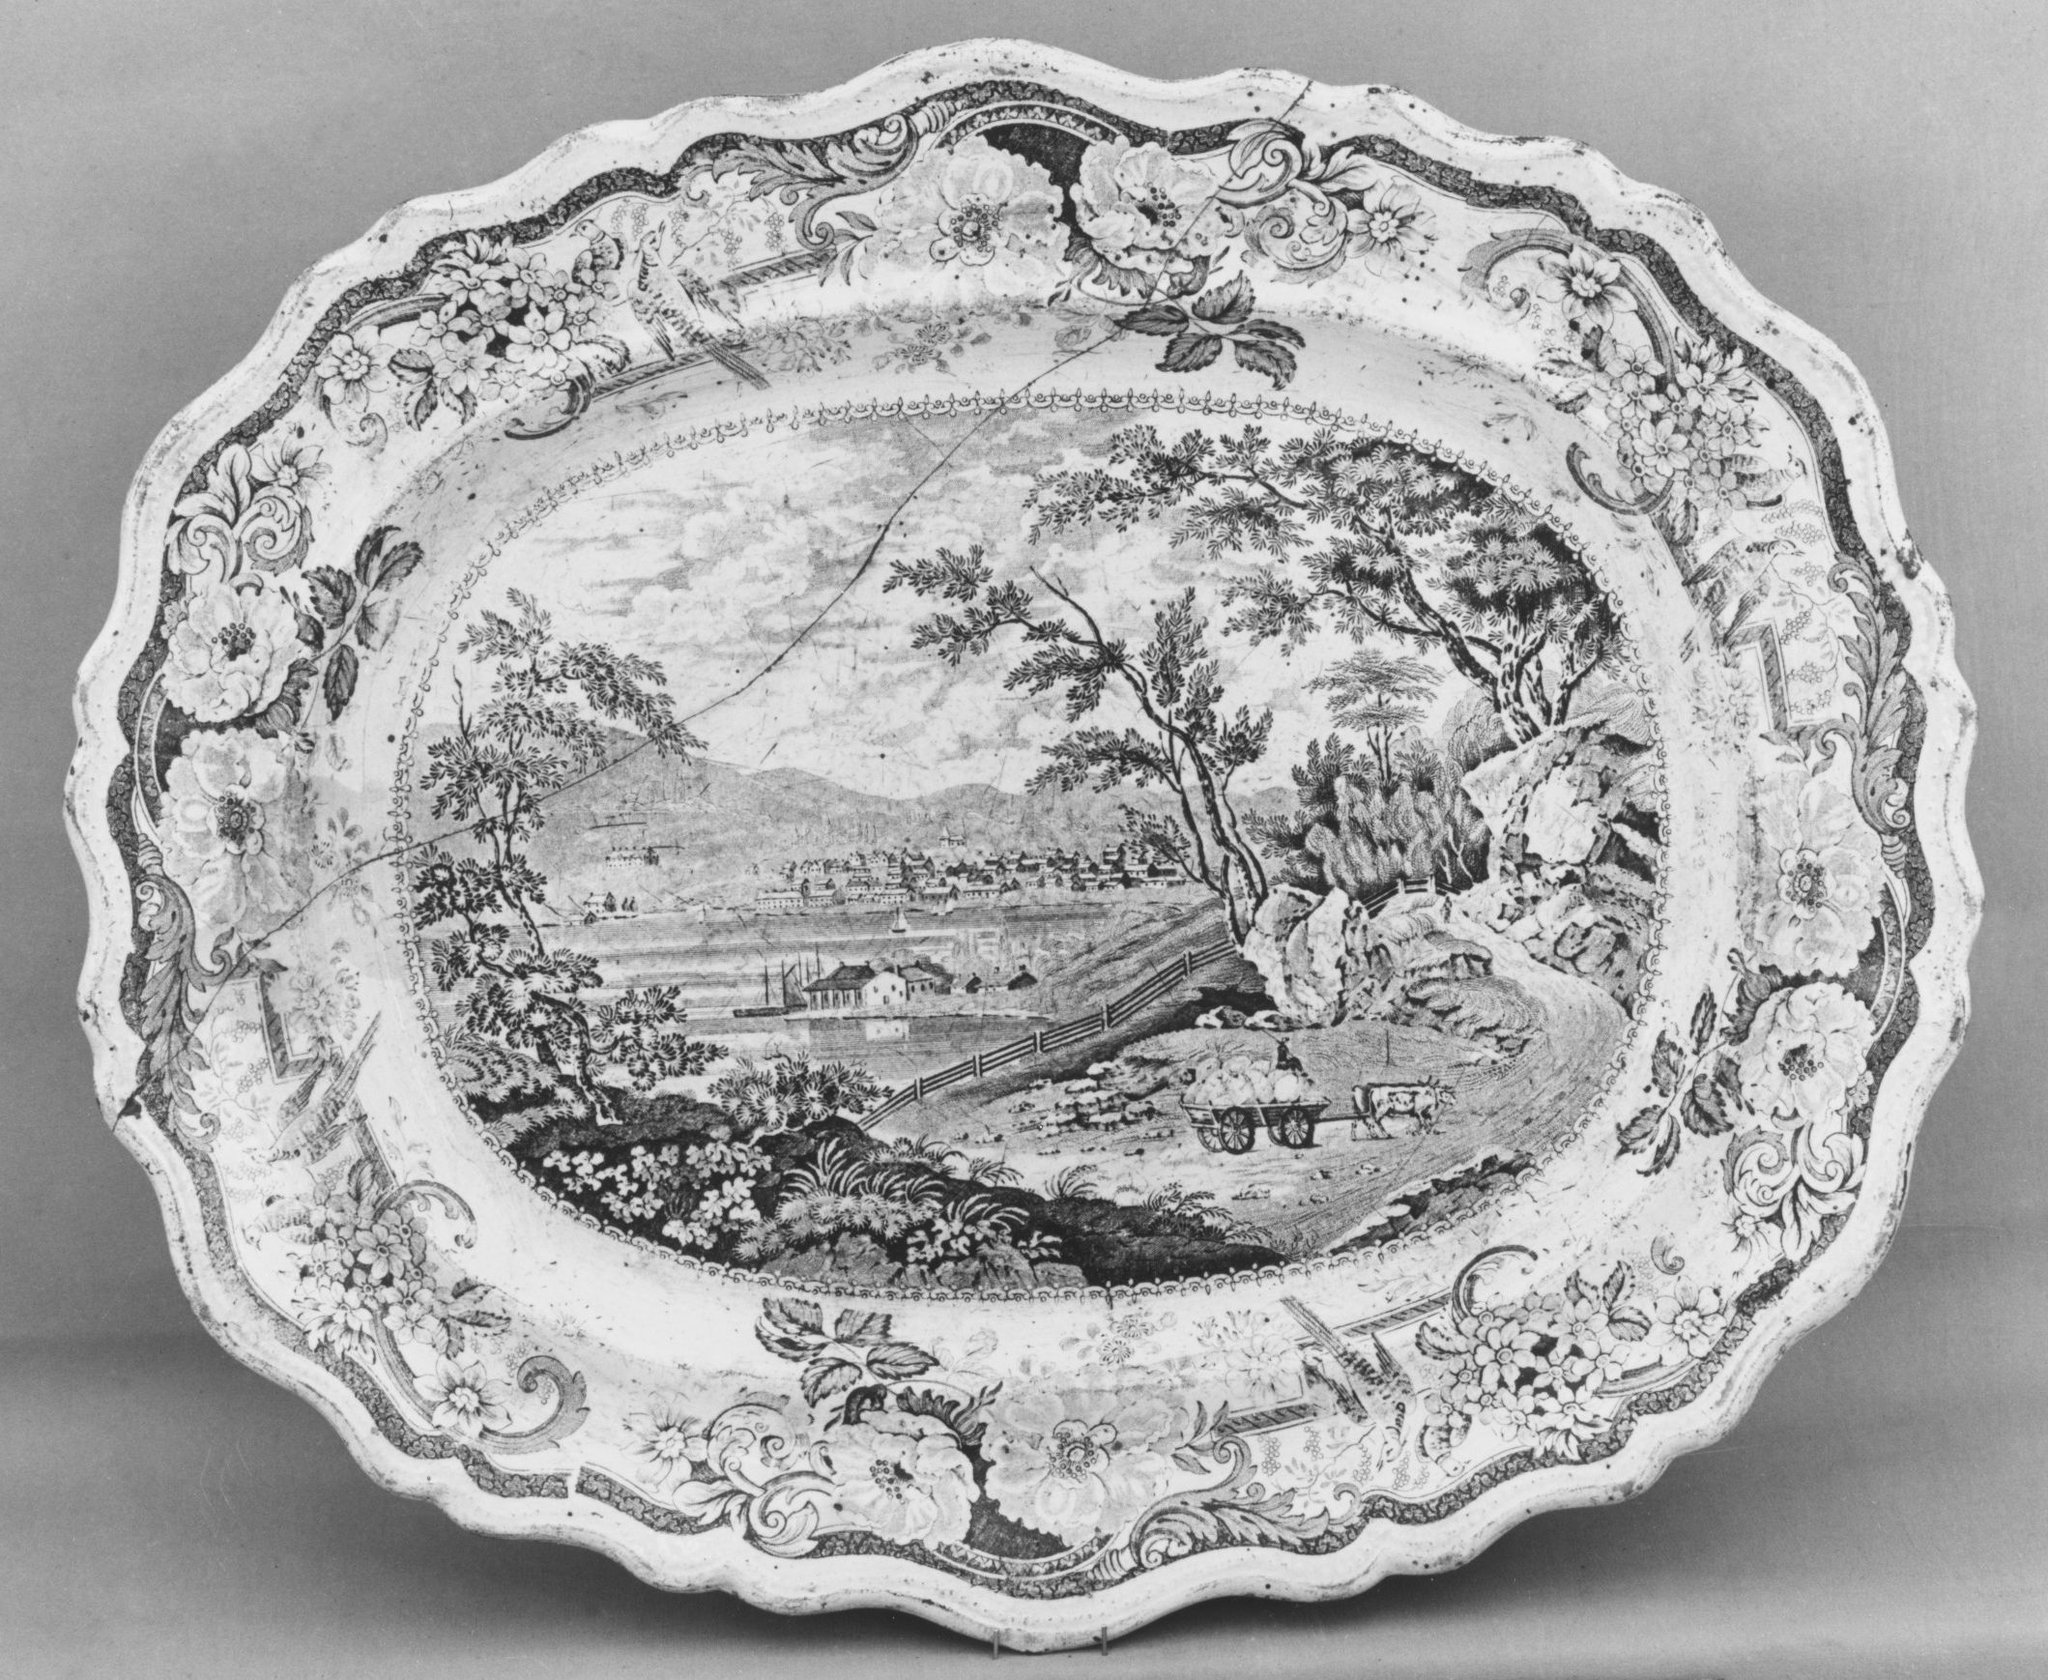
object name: platter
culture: british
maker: james and ralph clews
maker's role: maker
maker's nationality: british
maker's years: 1813-1836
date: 1825-1834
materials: earthenware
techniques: transfer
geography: england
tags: landscapes